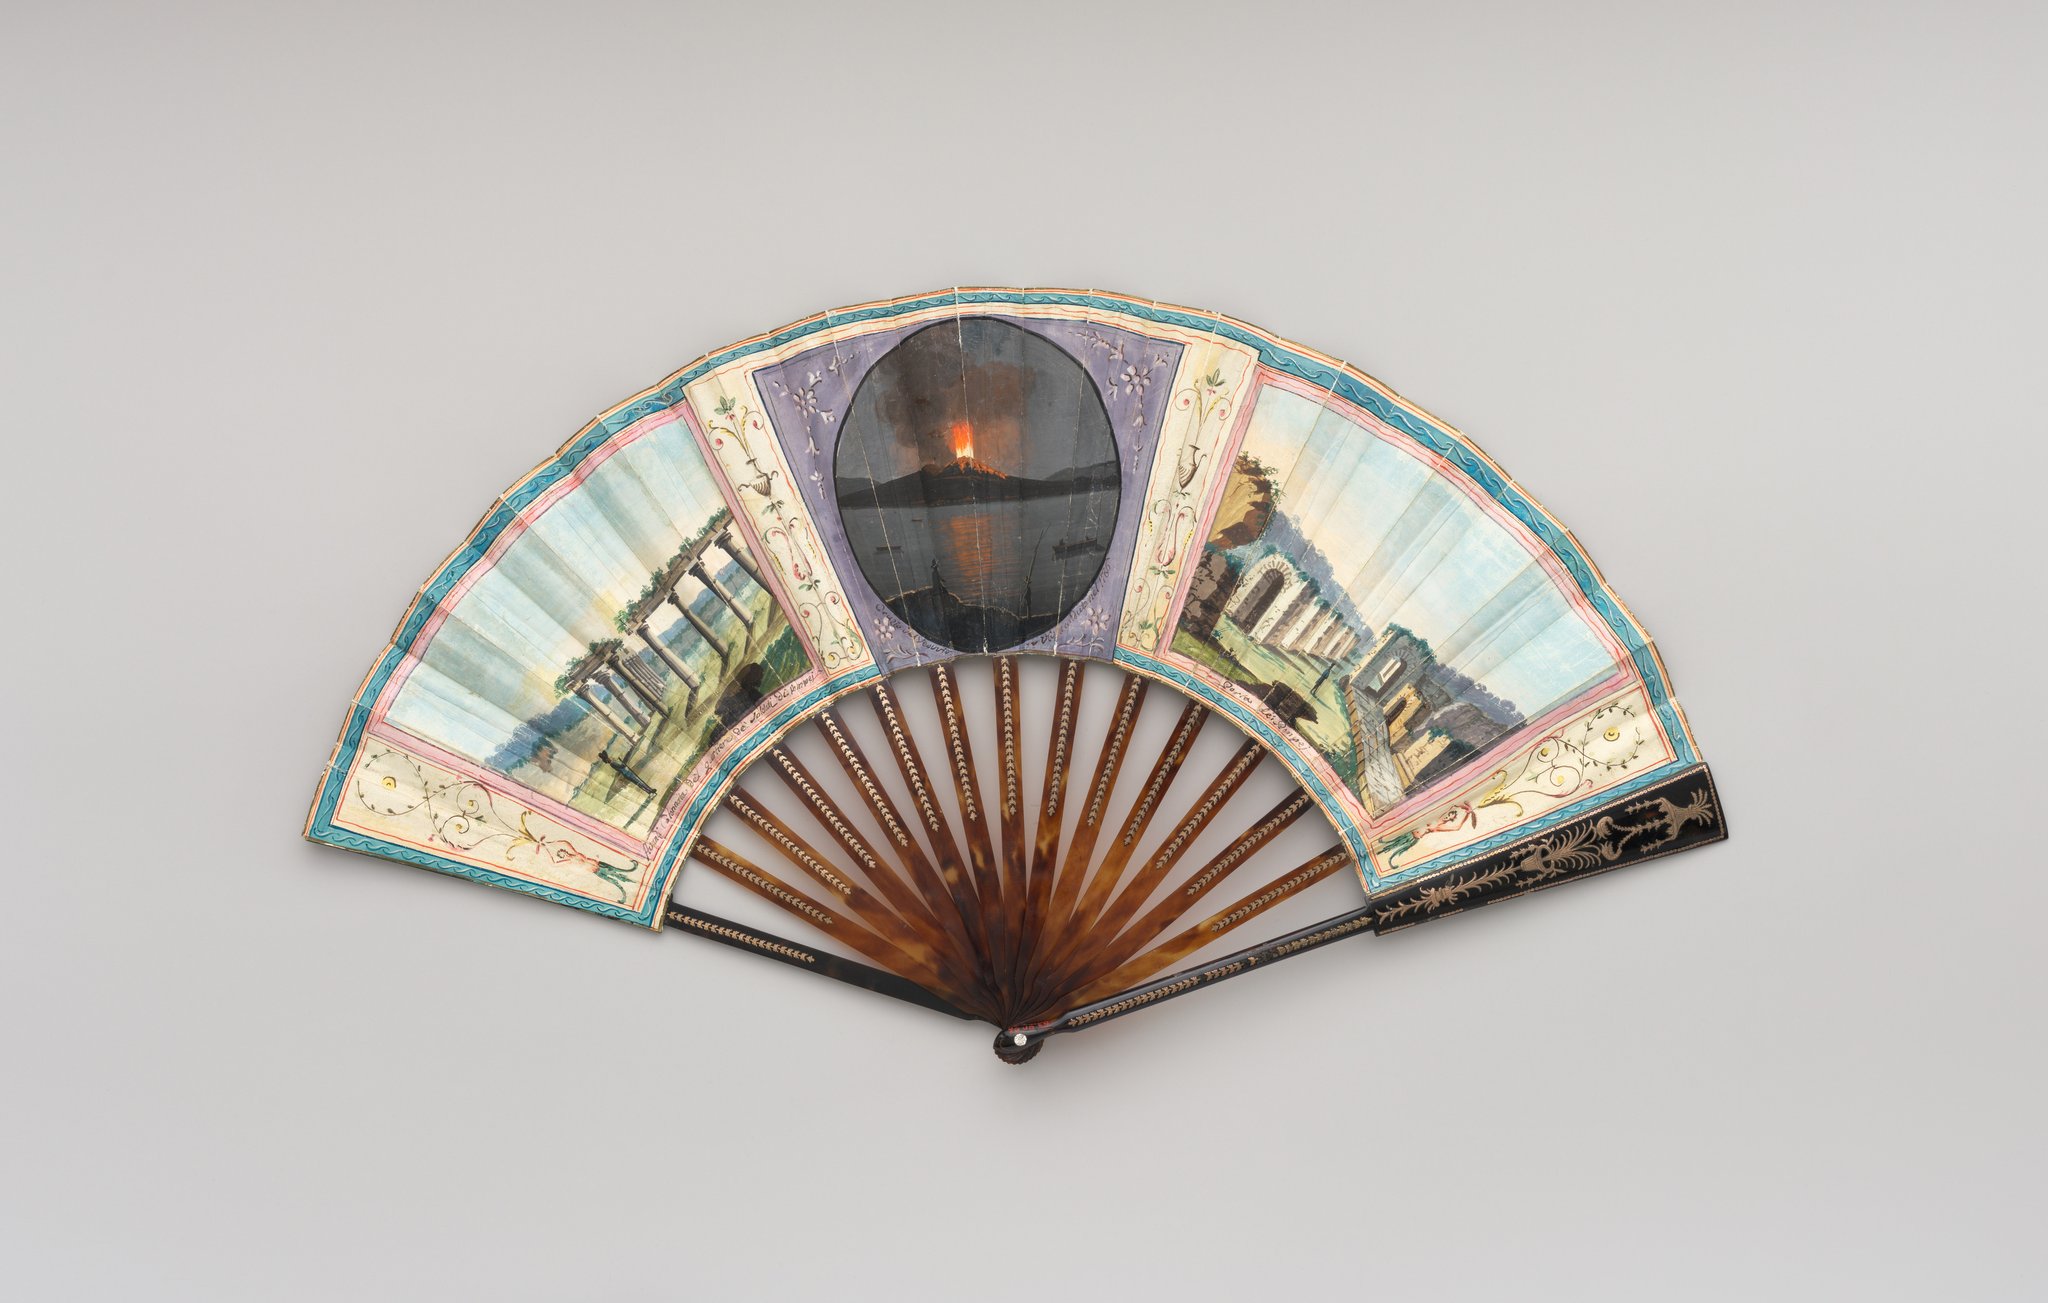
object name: fan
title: Folding Fan with representations of Pompeii and the 1786 eruption of Vesuvius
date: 1795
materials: gilt, glass, gouache, metal, parchment, shell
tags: buildings,volcanoes